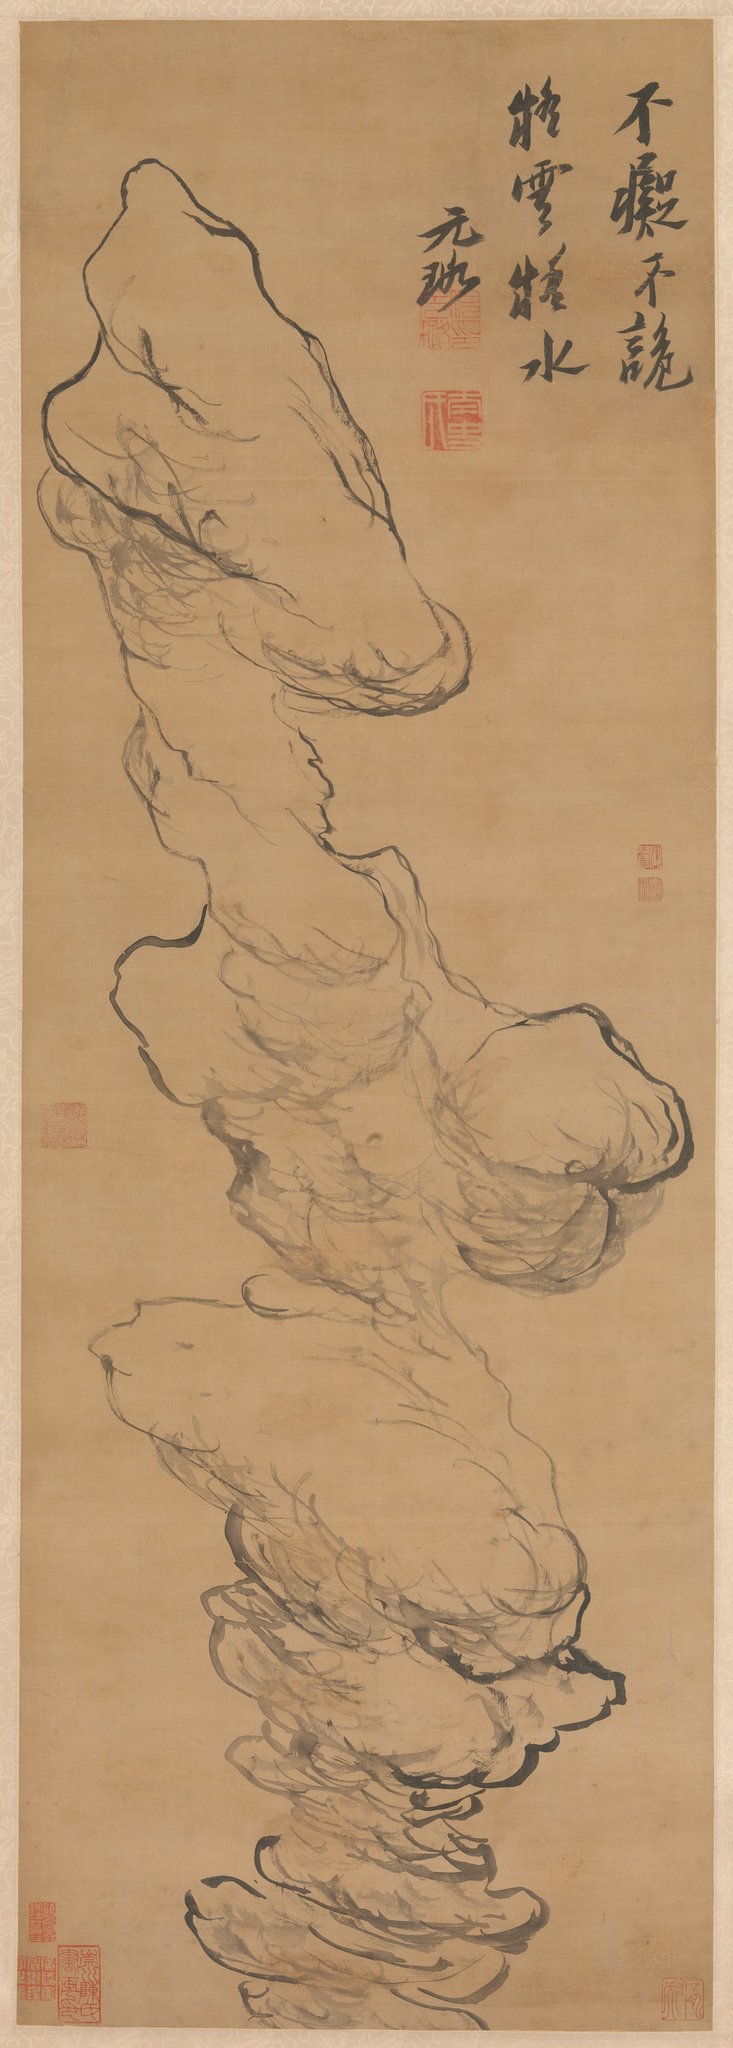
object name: hanging scroll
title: Cloud Rock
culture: chinese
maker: ni yuanlu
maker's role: artist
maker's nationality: chinese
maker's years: 1593-1644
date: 1501-1666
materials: ink, silk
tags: clouds